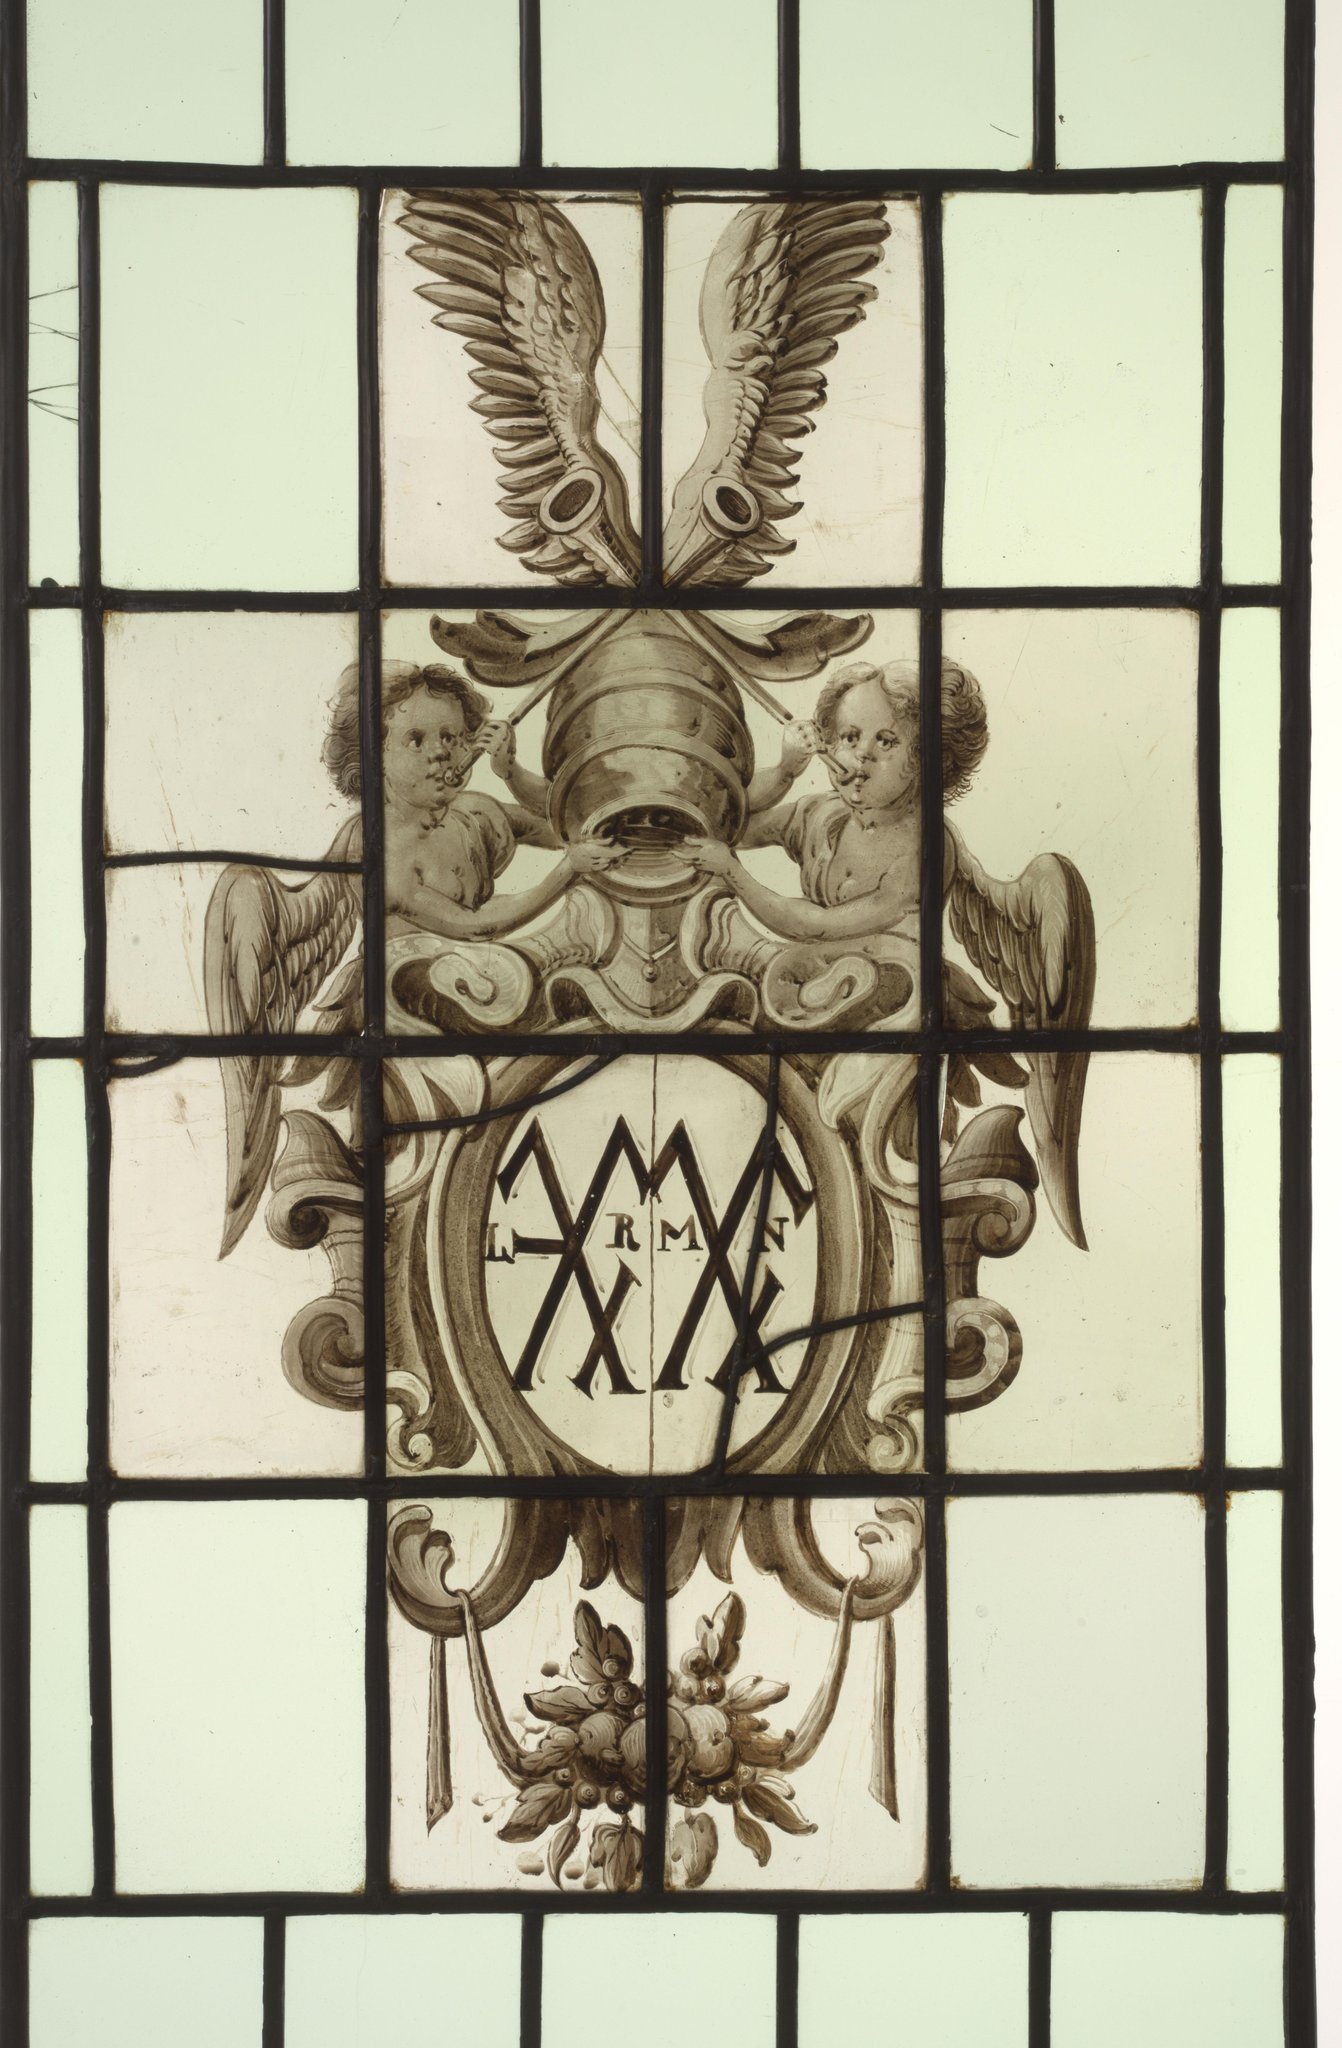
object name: wapenruit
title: Ruit met als helmteken twee trompetblazende engelen die een omgekeerde ton ophouden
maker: Anonymous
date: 1700-1900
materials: glass, lead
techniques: leading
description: Wapenruit met ornamenten in grisaille. Boven het wapenschild twee trompetblazende engelen die een omgekeerde ton ophouden.